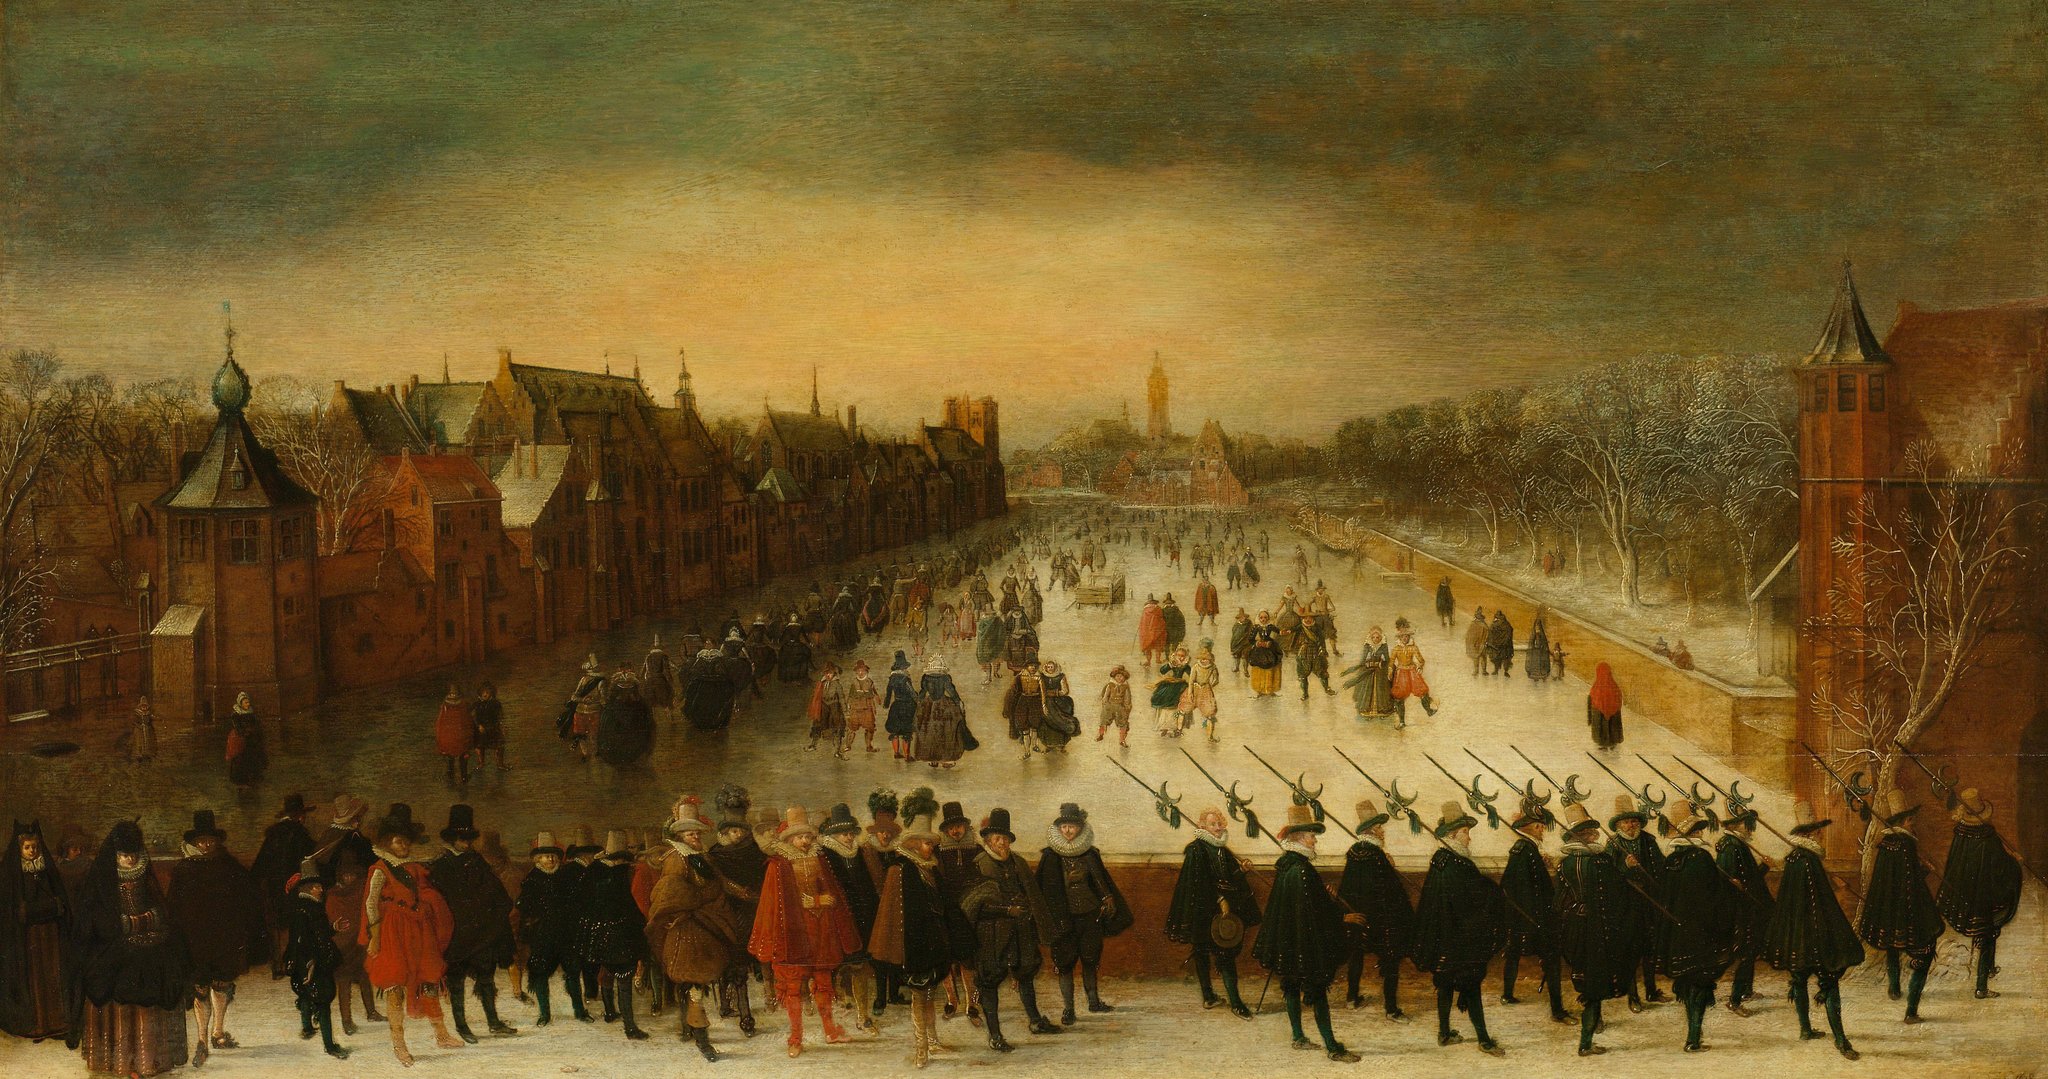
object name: painting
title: The Vijverberg, The Hague, in Winter, with Prince Maurits and his Retinue in the Foreground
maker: adam van breen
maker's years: 1584-1642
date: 1618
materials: oil, panel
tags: delft, frederick henry (prince of orange), maurice (prince of orange), skates (winter sports), canals, waters (in city)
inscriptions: signature and date, at bottom right: ‘A. v. Breen 1618’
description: Tegen de achtergrond van de Haagse hofvijver passeert Maurits met zijn lijfwacht en gevolg. De figuur rechts naast hem is zijn jongere broer en opvolger Frederik Hendrik. Direct achter hen staan de belangrijkste hofdienaren. Allen dragen elegante, modieuze kleding. De rijk geklede vrouw links is mogelijk Maurits’ geliefde Margaretha van Mechelen.